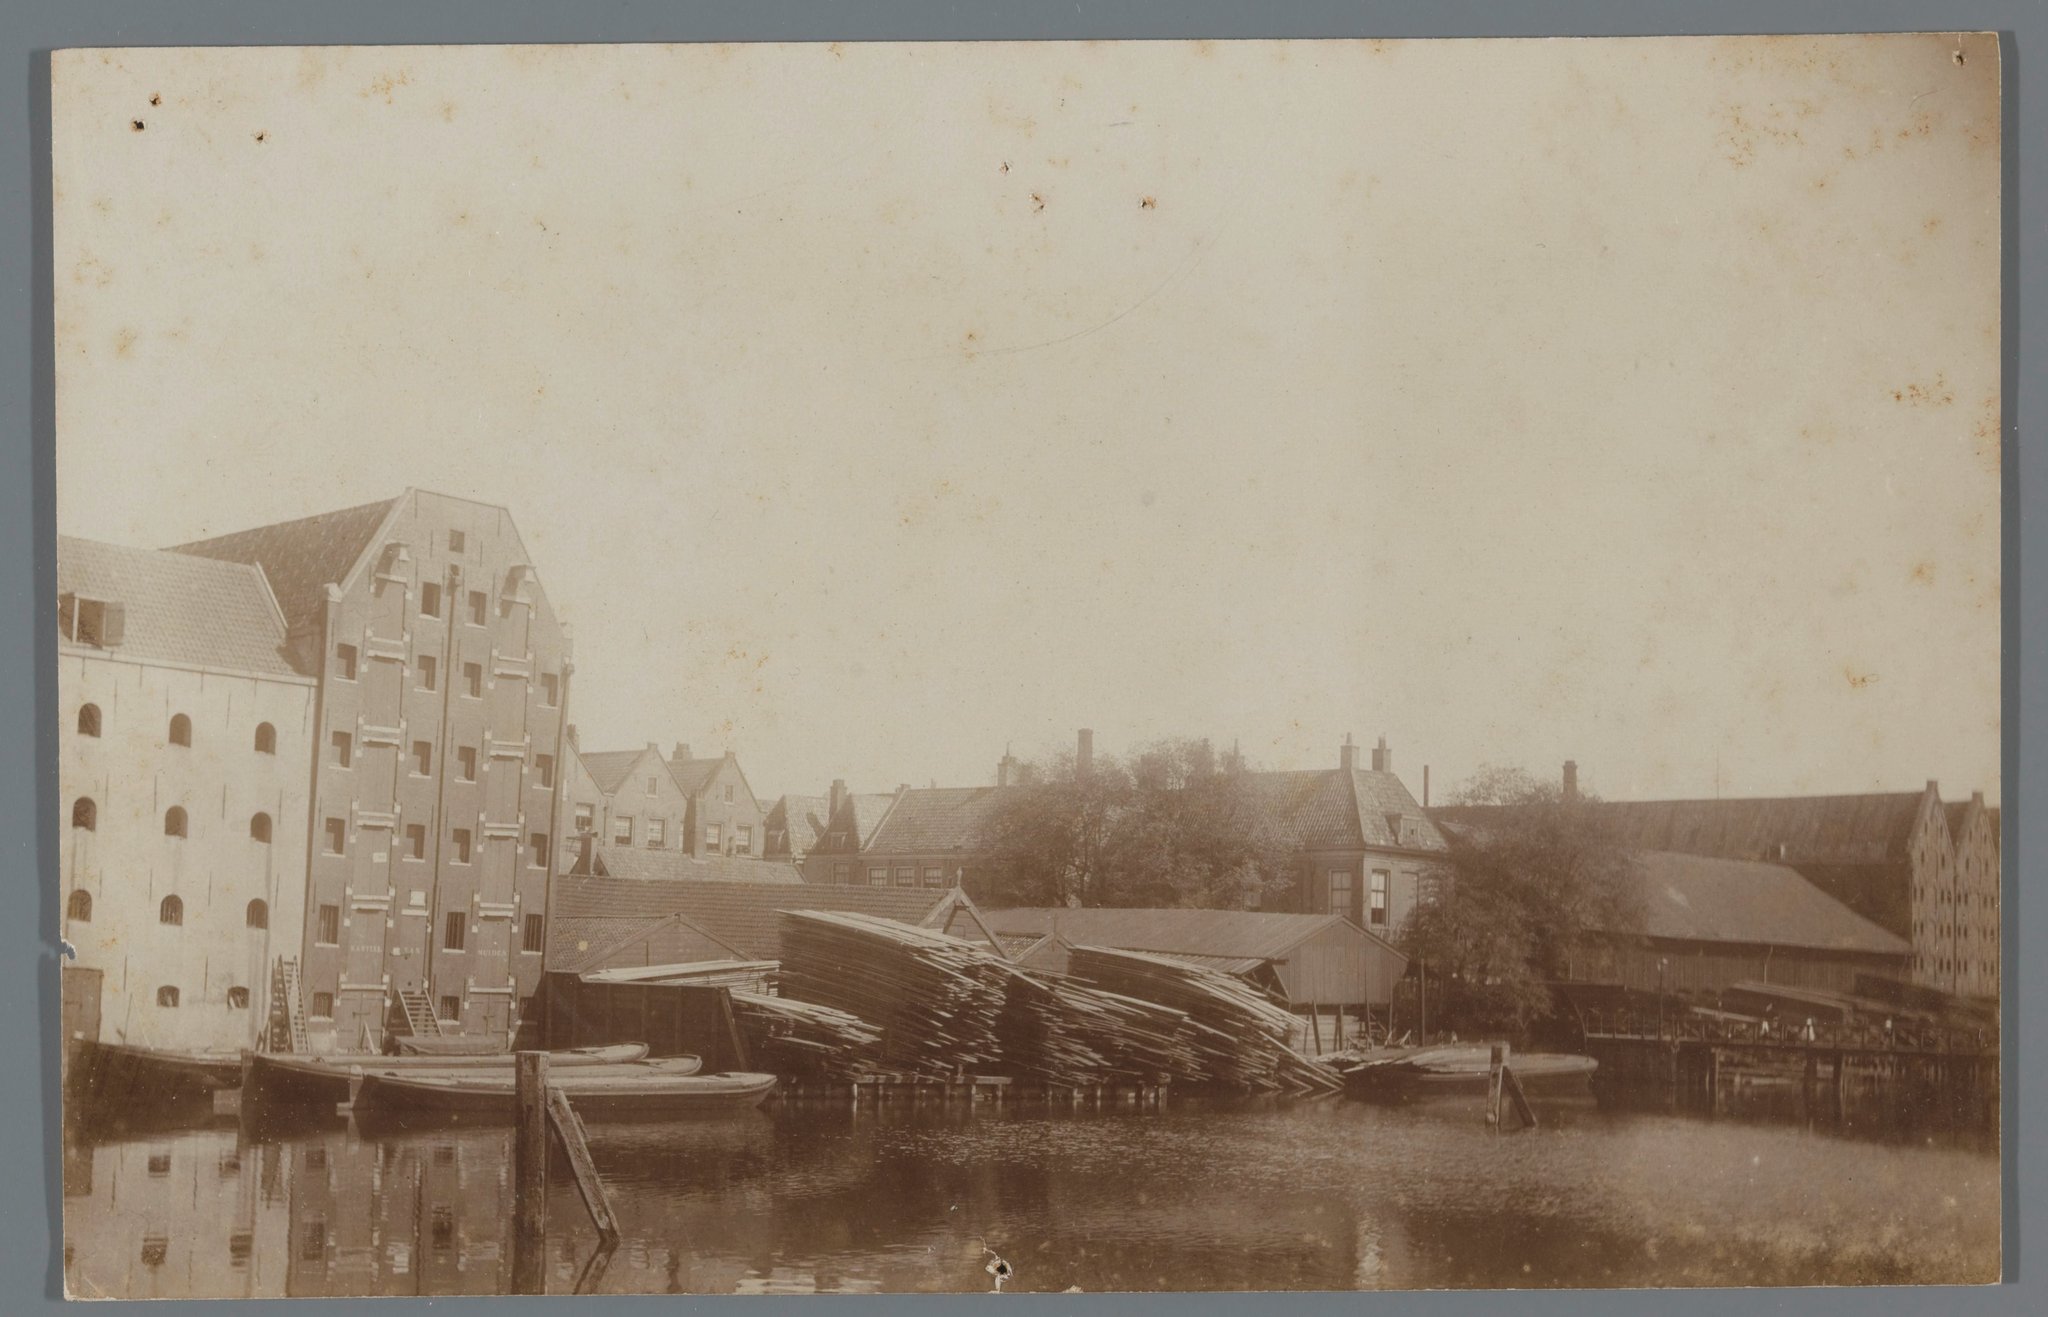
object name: photograph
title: Gezicht op een gracht met pakhuizen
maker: cornelia hendrika jonker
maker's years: 1874-1924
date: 1880-1940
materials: photographic support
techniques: collodion silver print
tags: warehouse (~ harbour), canal